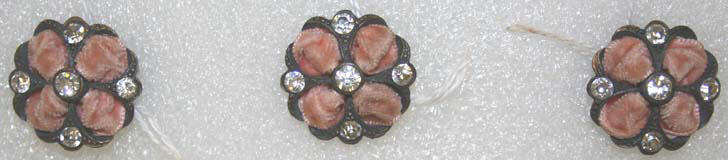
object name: button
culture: french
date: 1800-1899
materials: metal